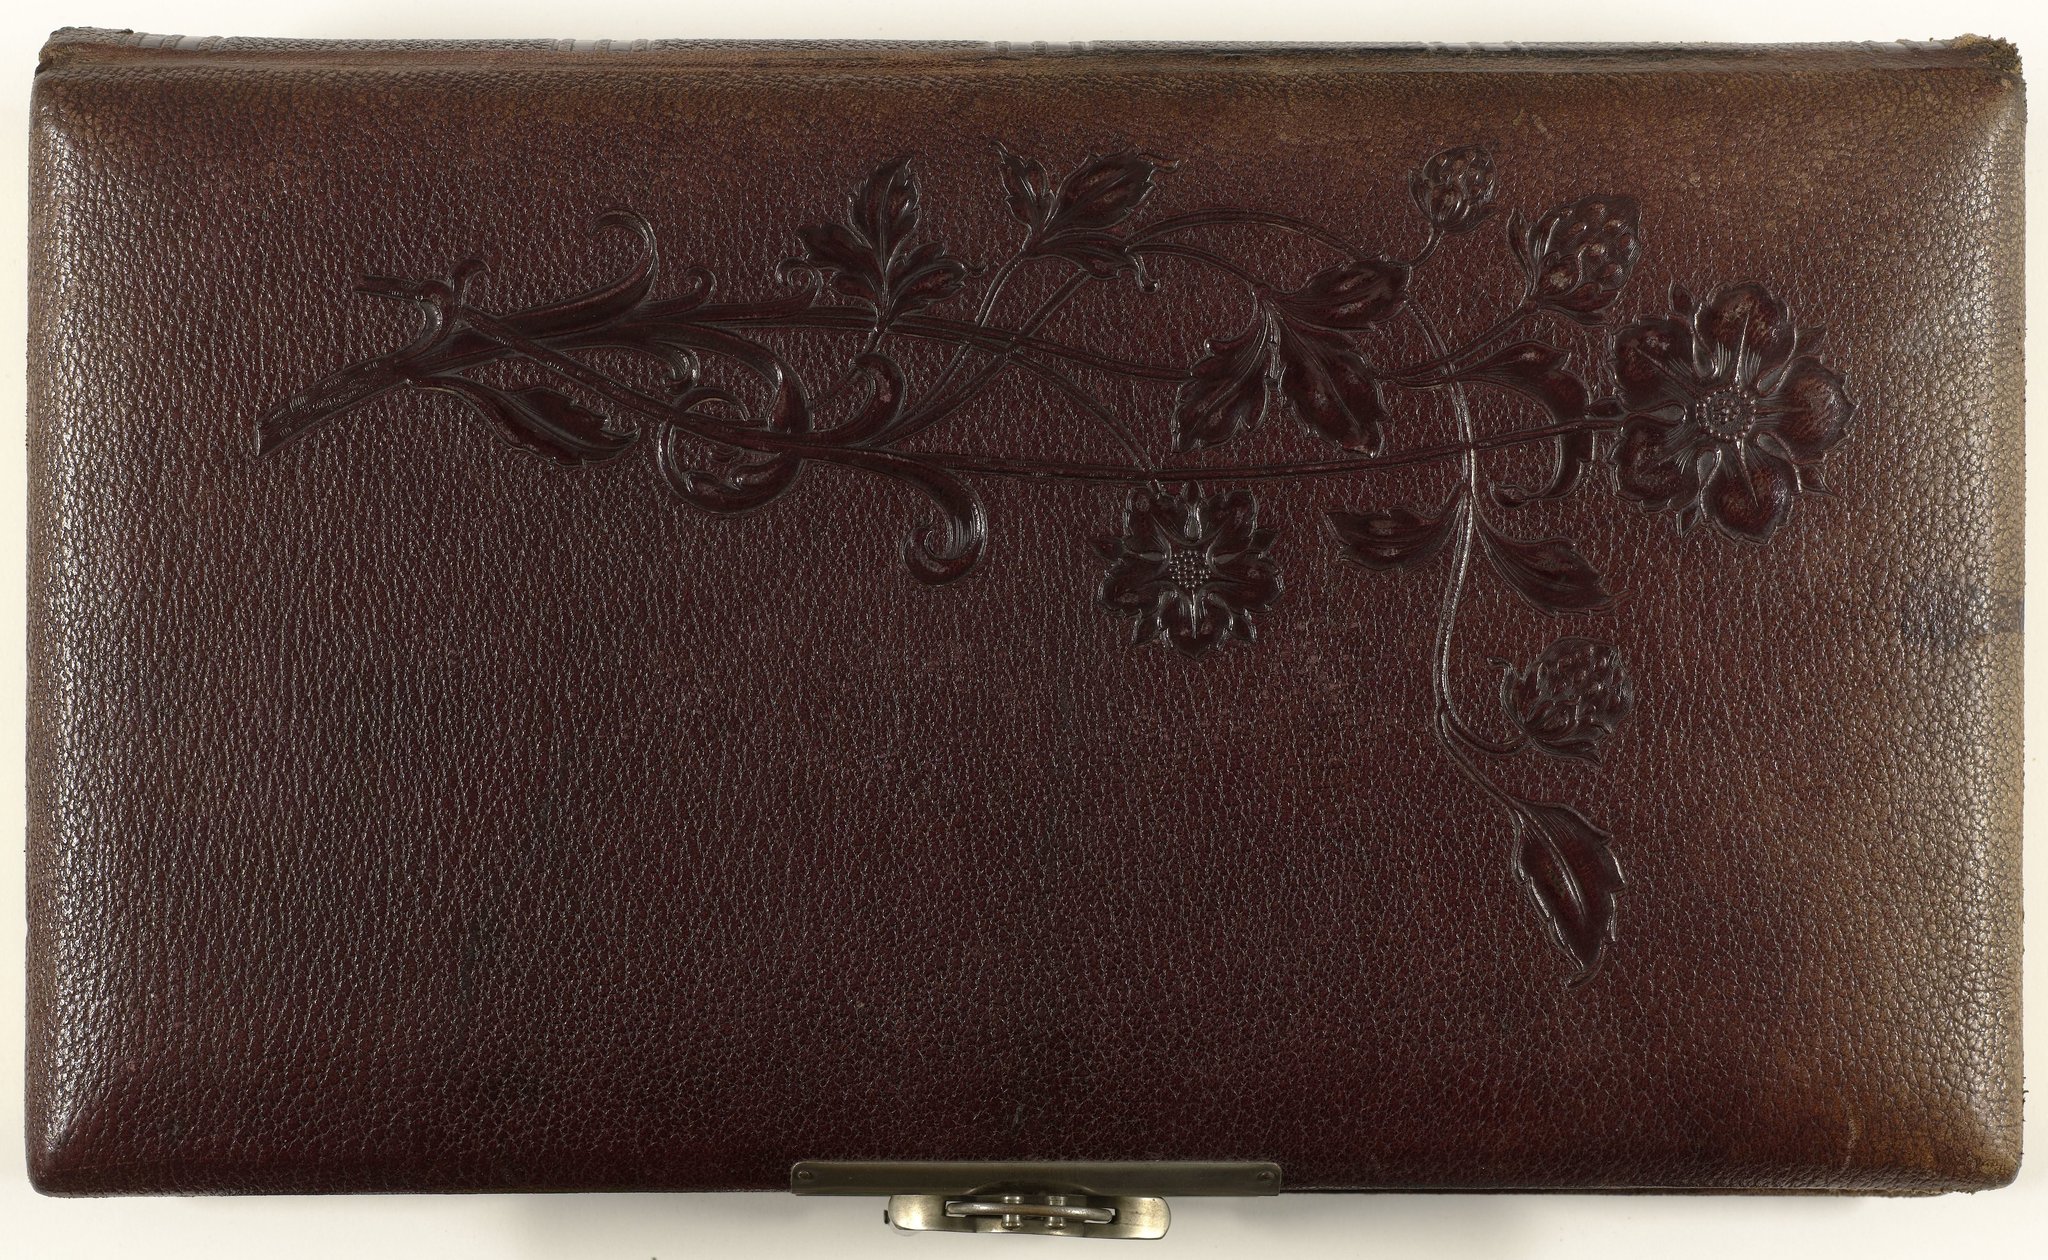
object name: slip in album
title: Nederlands familiealbum met 89 foto's en een prent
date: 1900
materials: cardboard, leather, metal, paper, photographic support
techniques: albumen print, photograph, decorated paper, gelatin silver print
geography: netherlands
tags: flower culture, historical persons - bb - woman, child, historical persons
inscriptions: collector's mark: ‘DIENST/ VERSPREIDE/ RIJKSKOLLEKTIES/ (...) A 988’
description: Fotoalbum met in totaal 89 foto's en 1 prent op 28 pagina's. Het album bevat 13 kabinetfoto's, 53 cartes-de-visite en 21 foto's van andere formaten in met gouden lijnen omkaderde passe-partouts. Daarnaast zitten er 3 losse foto's achterin het album. Niet alle passe-partouts in het album zijn gevuld. Afgebeeld zijn portretten van onbekende mannen, vrouwen en kinderen, enkele interieurs en enkele foto's van tuinders. De foto's zijn gemaakt door verschillende Nederlandse fotografen, waaronder Cornelis Johannes Lodewicus Vermeulen, Machiel Hendricus Laddé en Albert Greiner. Van 32 foto's is de fotograaf anoniem.